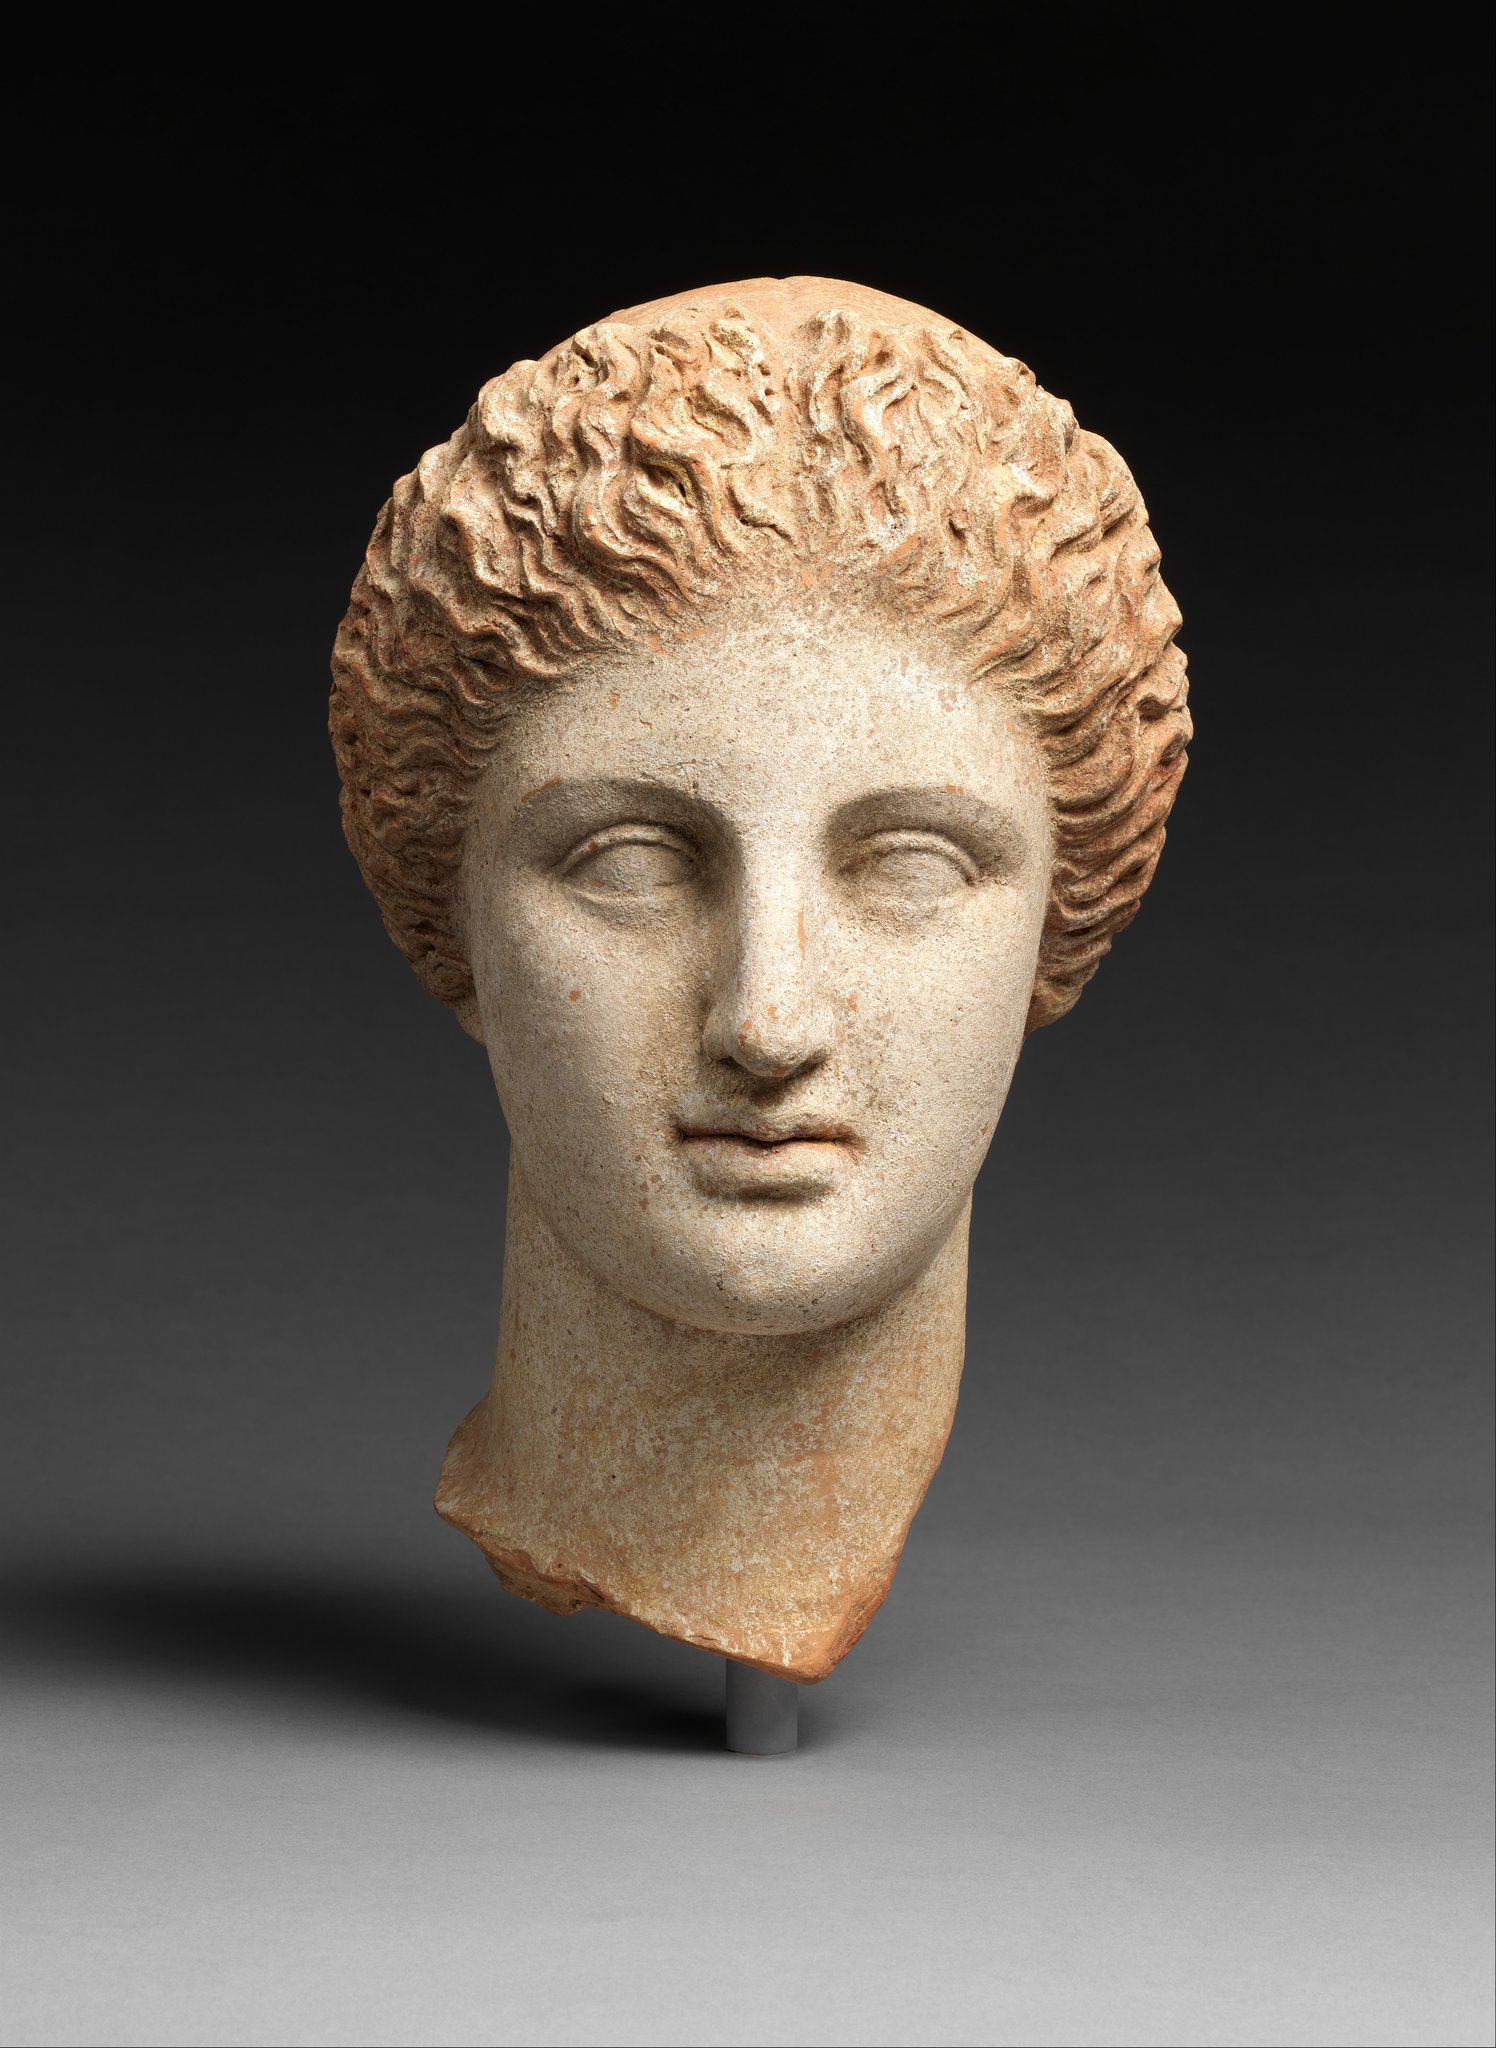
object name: sculpture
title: Terracotta head of a woman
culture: greek, tarentine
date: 334-301 BCE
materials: terracotta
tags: heads,women